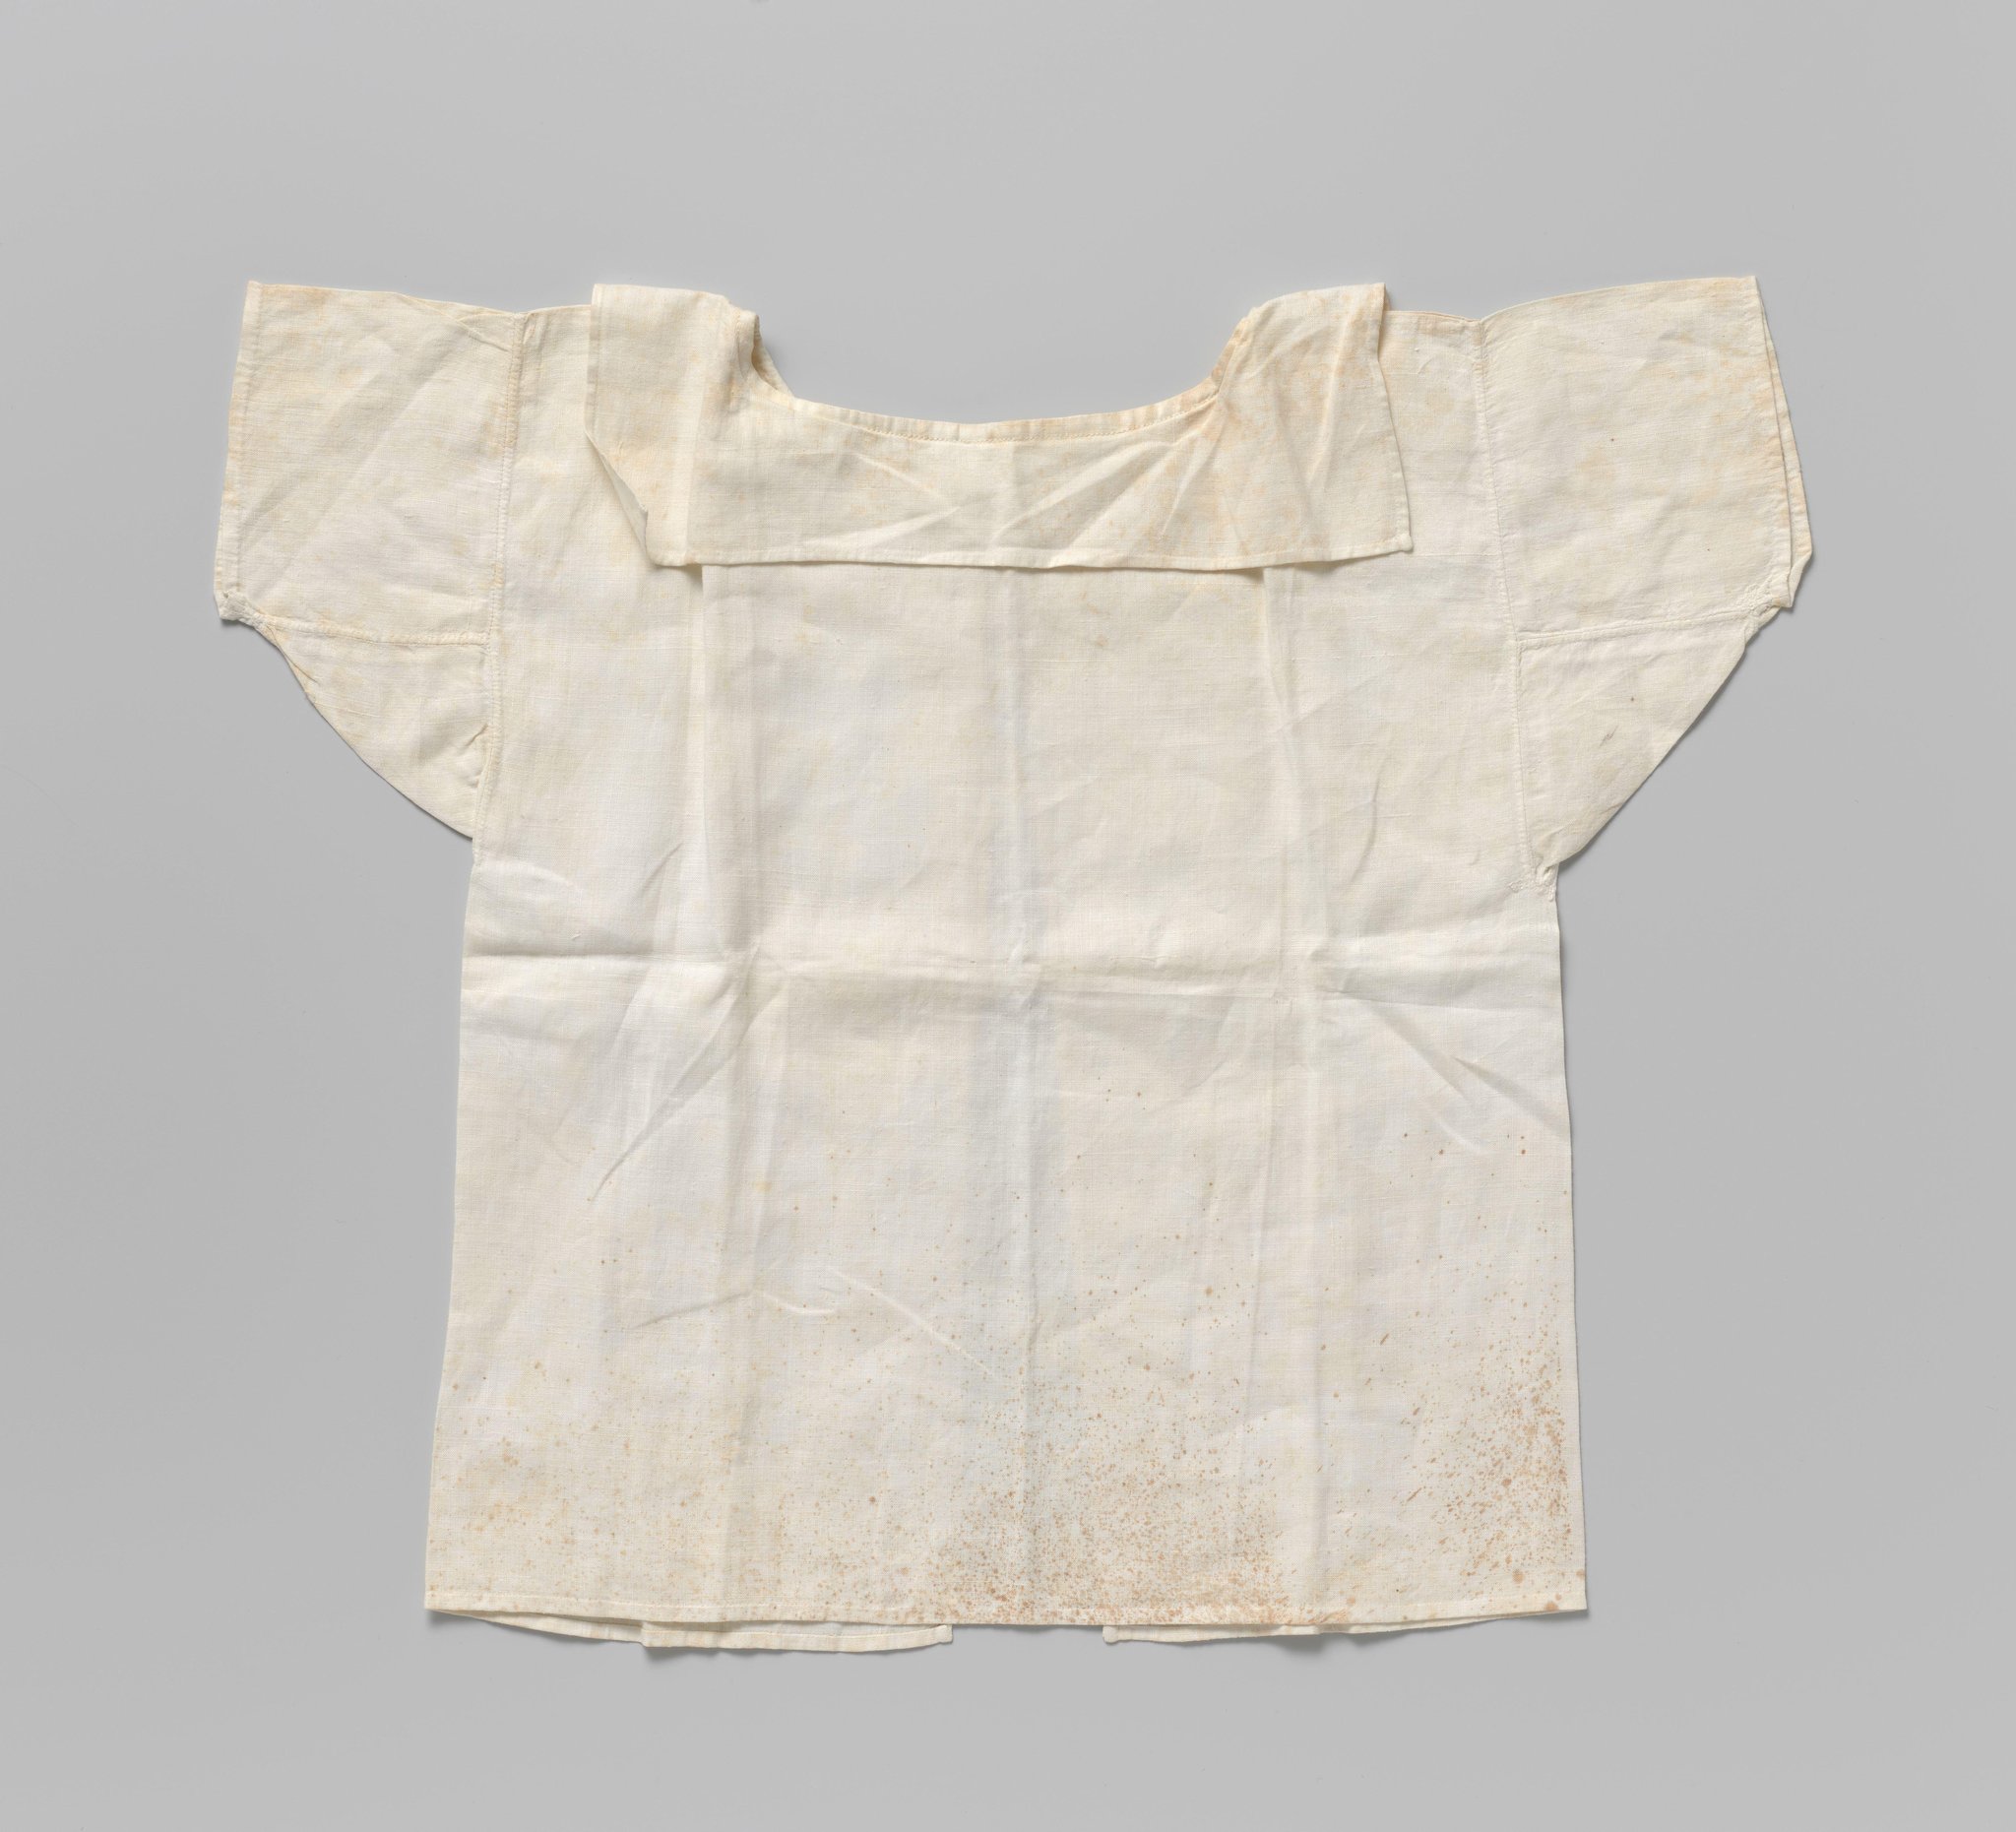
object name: chemise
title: Kinderhemd van fijn wit linnen met een rechte platte kraag, halssplit en korte mouw; gemerkt in roze kruissteek: DCM12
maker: Anonymous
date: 1785-1815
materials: linen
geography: netherlands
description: Kinderhemd van fijn wit linnen met een rechte platte kraag, halssplit en korte mouw; gemerkt in roze kruissteek: DCM12.